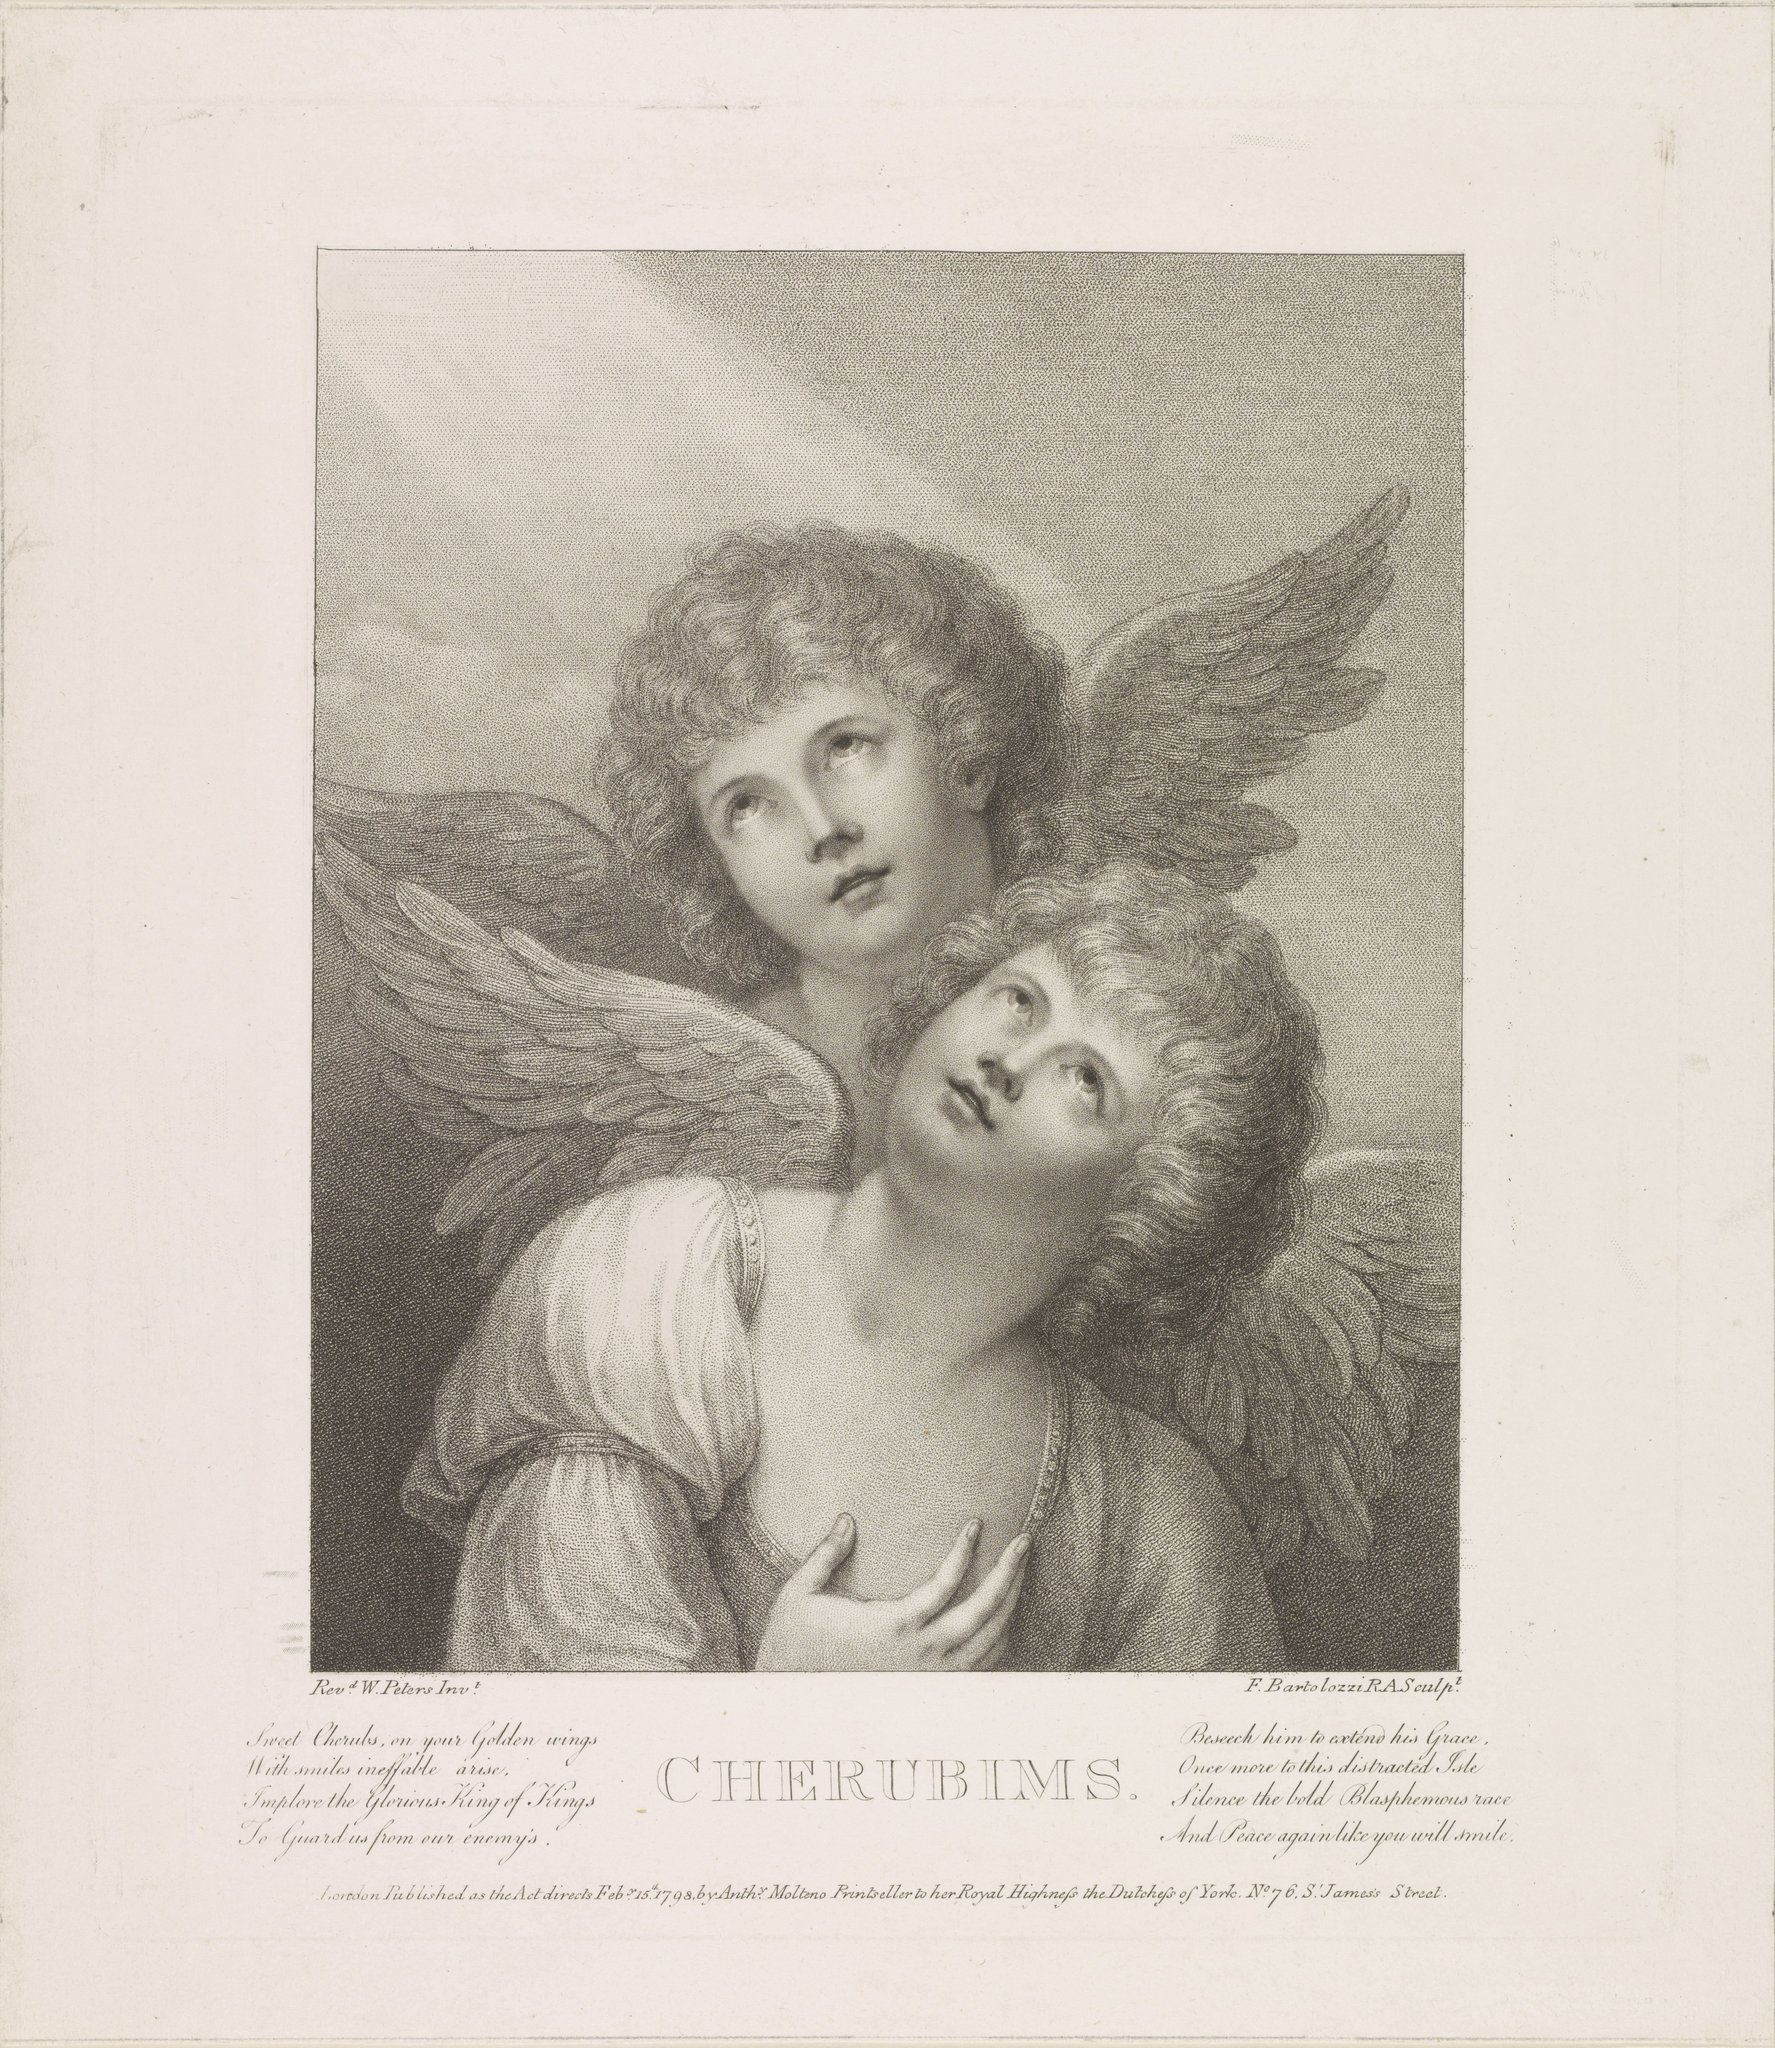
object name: print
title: Engelen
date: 1790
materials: paper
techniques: etching, engraving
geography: london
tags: angels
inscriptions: collector's mark: Lugt 2233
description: Twee engelen die omhoog kijken. In ondermarge titel en vers in het Engels in twee kolommen.